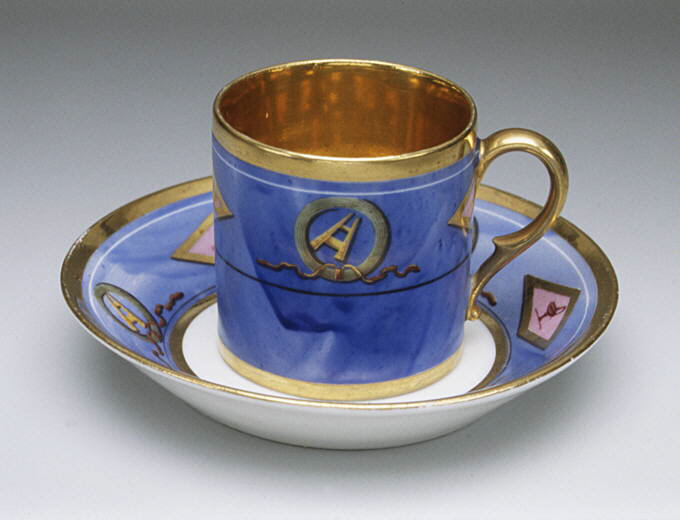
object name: cup and saucer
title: Cups and saucers (3)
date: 1800-1810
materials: hard paste porcelain